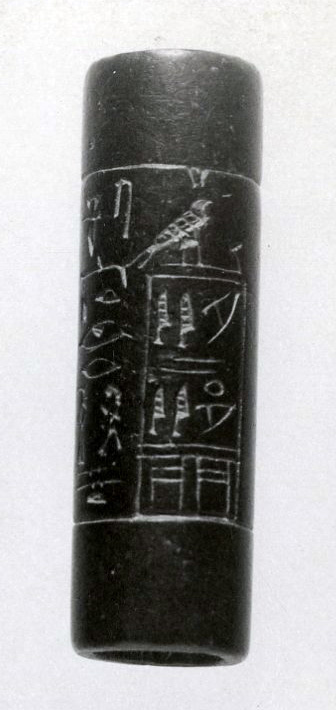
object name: cylinder seal, pepi i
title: Cylinder Seal with the Name of Pepi I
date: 2289-2255 BCE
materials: stone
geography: egypt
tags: hieroglyphs